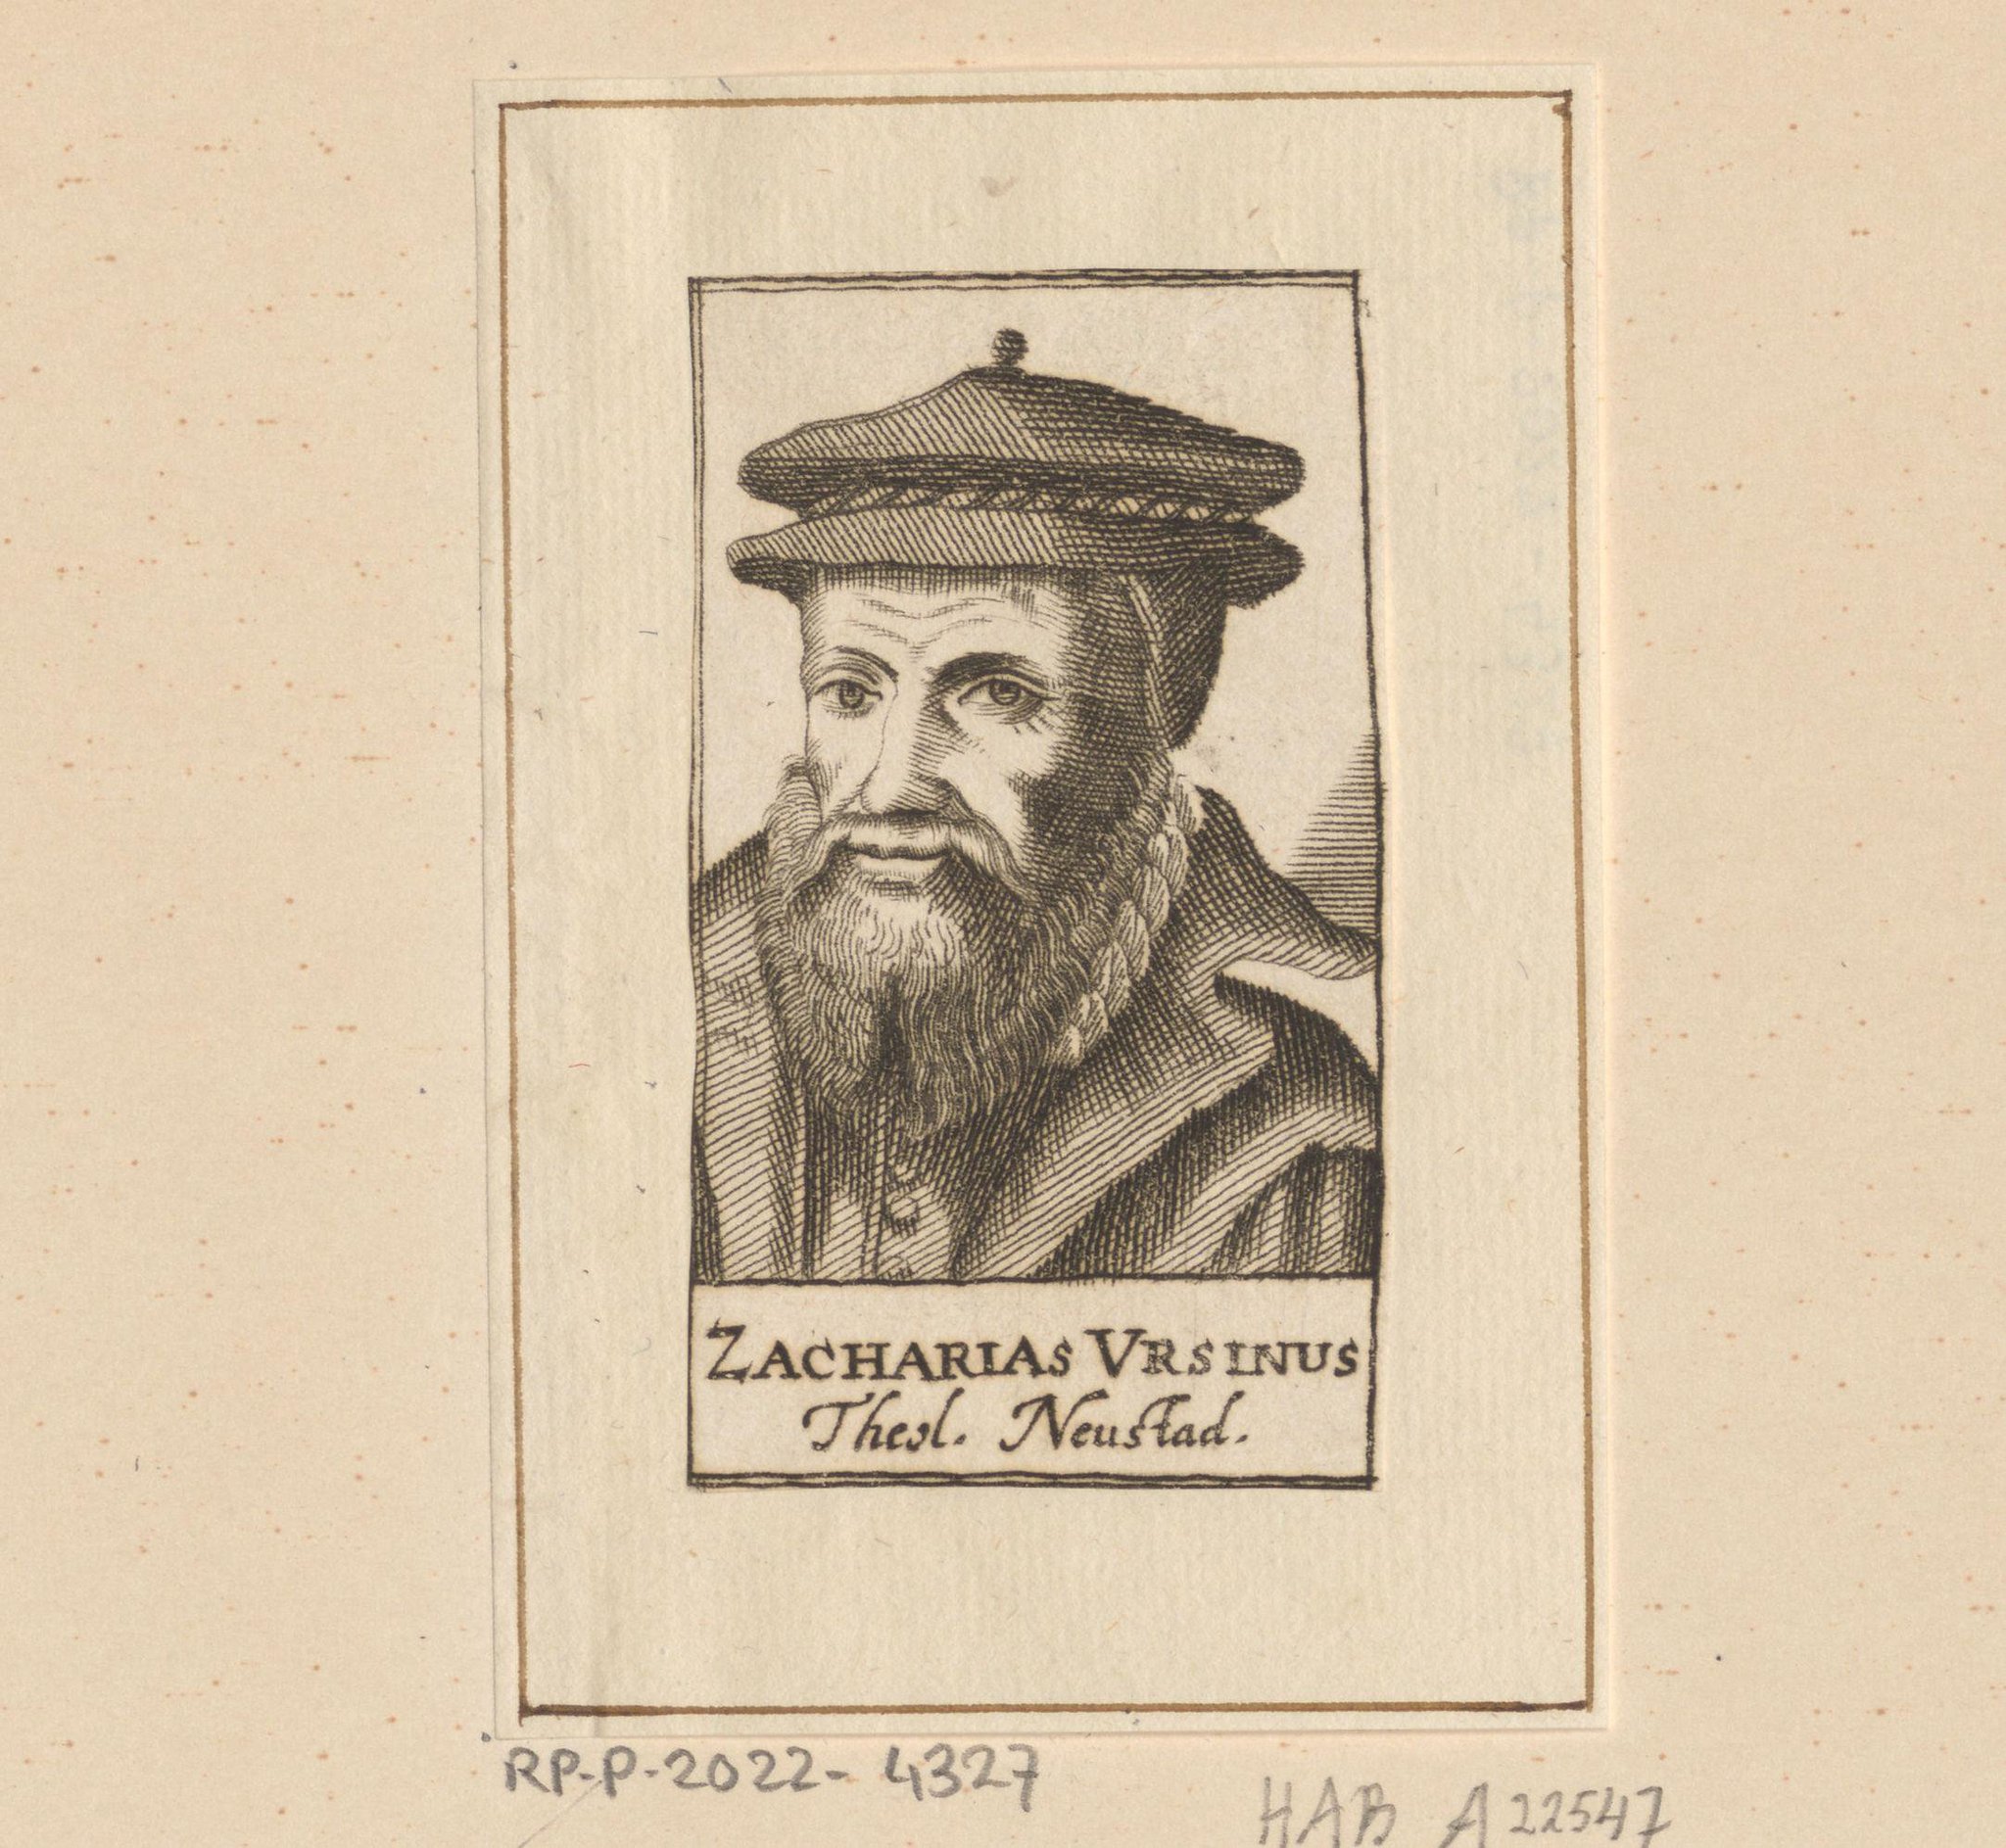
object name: book illustration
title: Portret van Zacharias Ursinus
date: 1688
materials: paper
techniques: engraving, etching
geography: nuremberg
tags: theologian, historical persons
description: Prent uit: Freher, Paul. Theatrum virorum eruditione clarorum. Neurenberg: Johann Hoffmann, 1688.